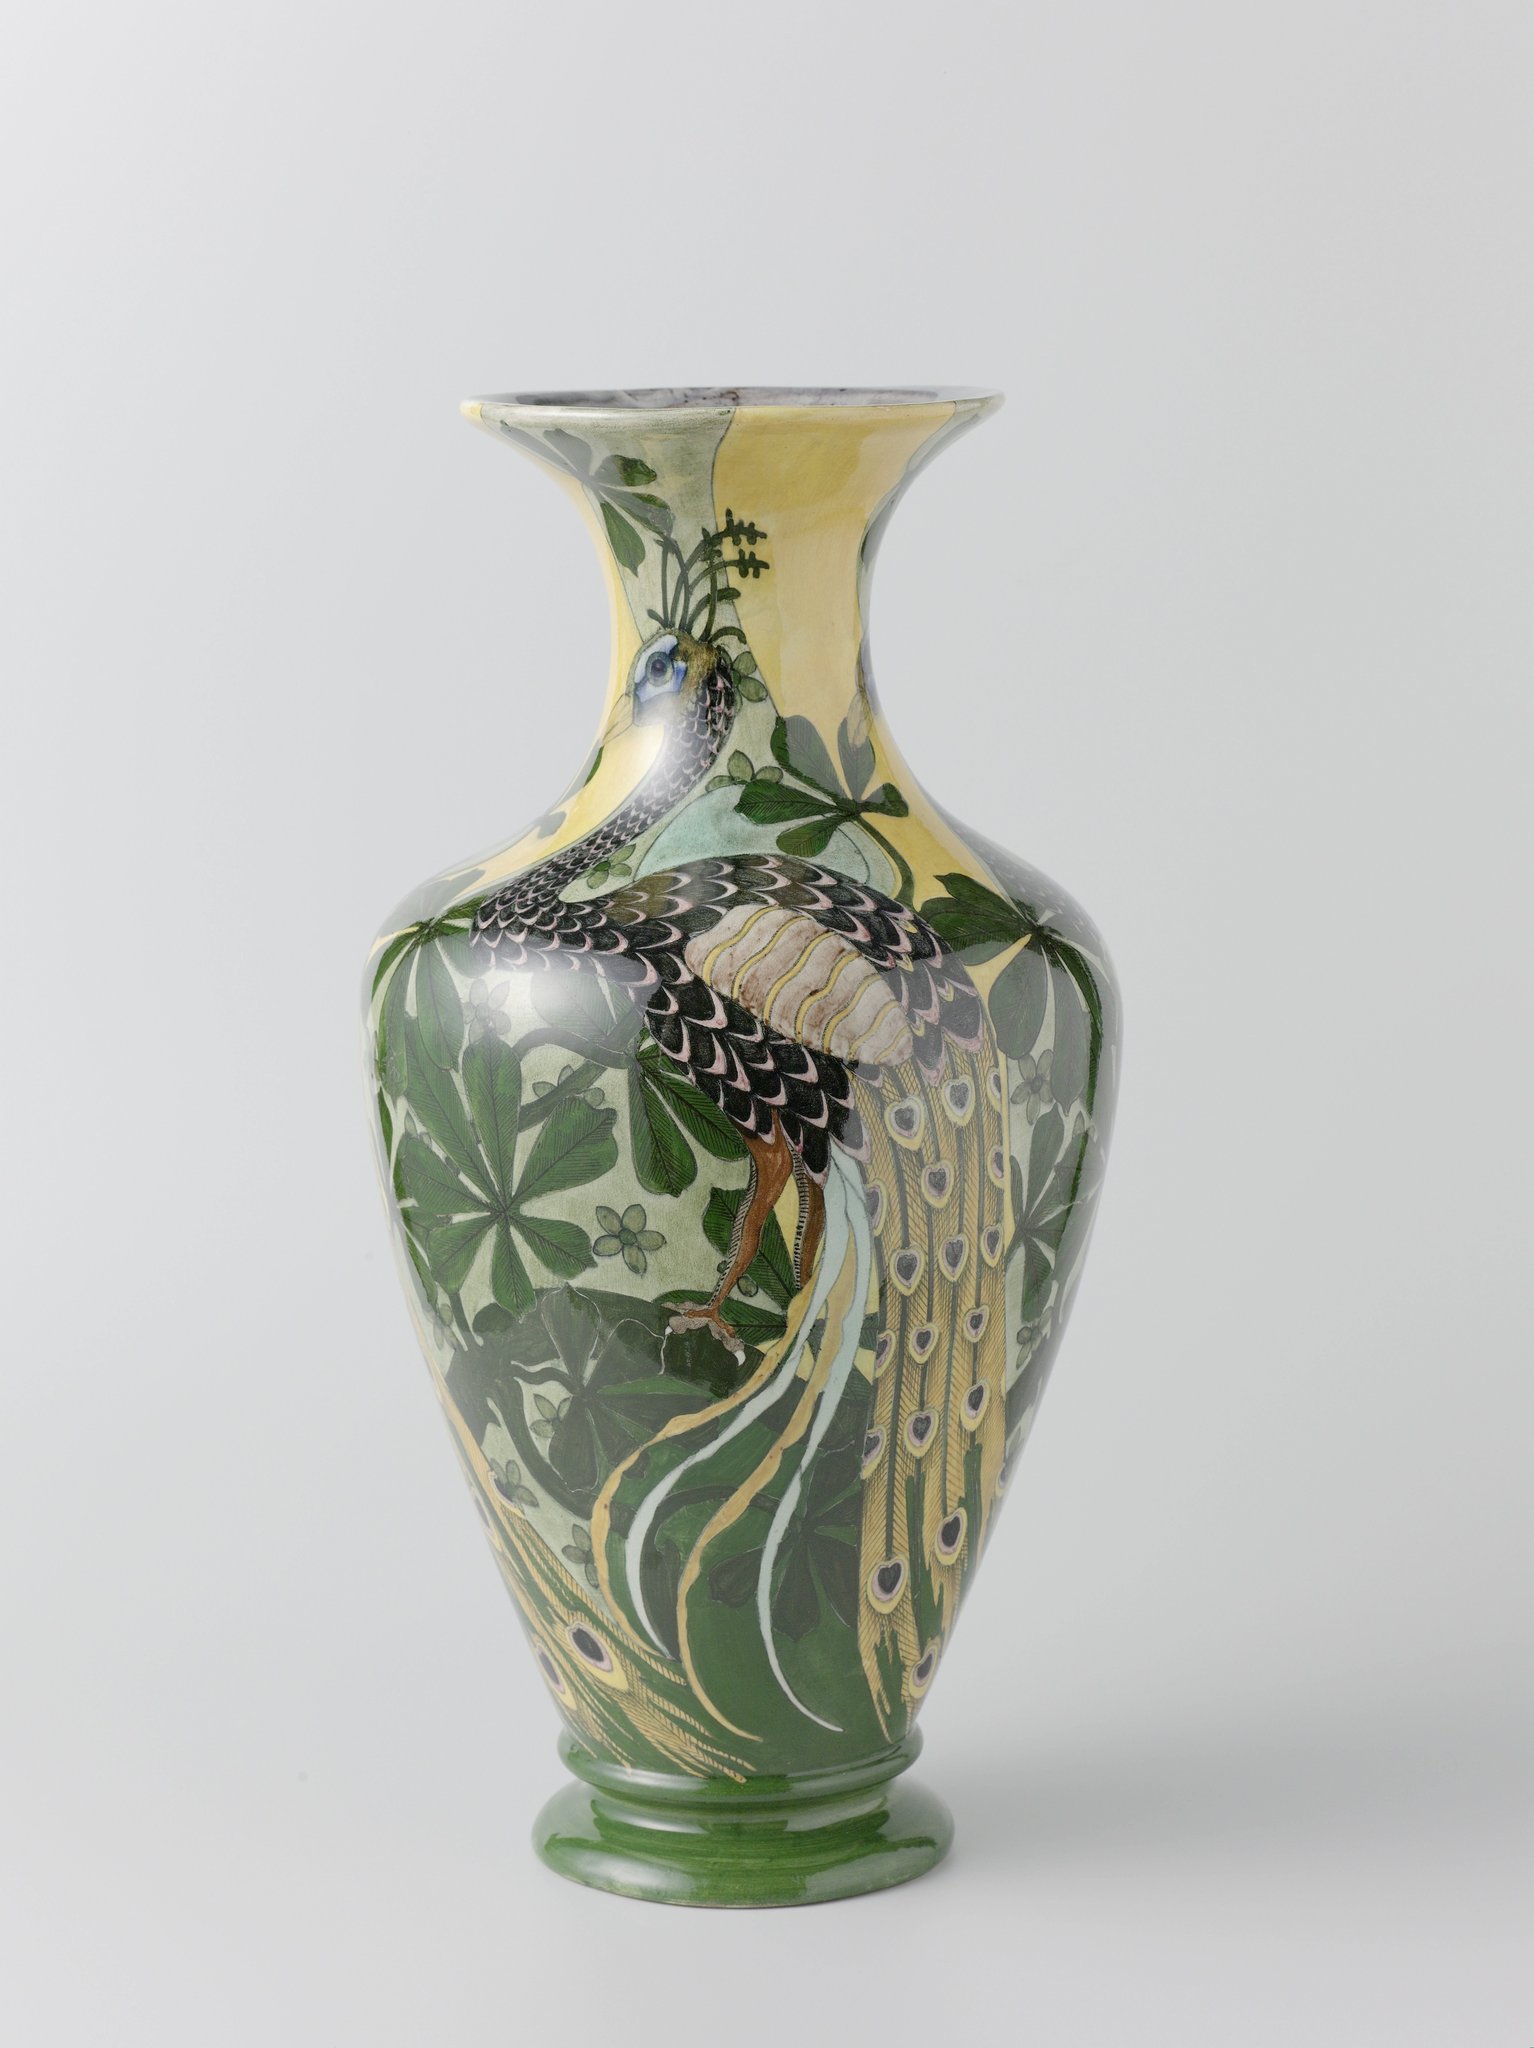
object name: vase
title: Vaas met pauwen en bladeren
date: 1895-1904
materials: stoneware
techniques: painted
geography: purmerend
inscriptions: mark: ‘klomp, NB, C. (?), Faience de Purmerende Hollande, Dec: A en 1075 en monogram KR.’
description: Vase. Earthenware. Purmerend, 1898, made by Firma Wed. N.S.A. Brantjes, decorated by K.R., factory under the direction of the widow of N.S.A. Brantjes.